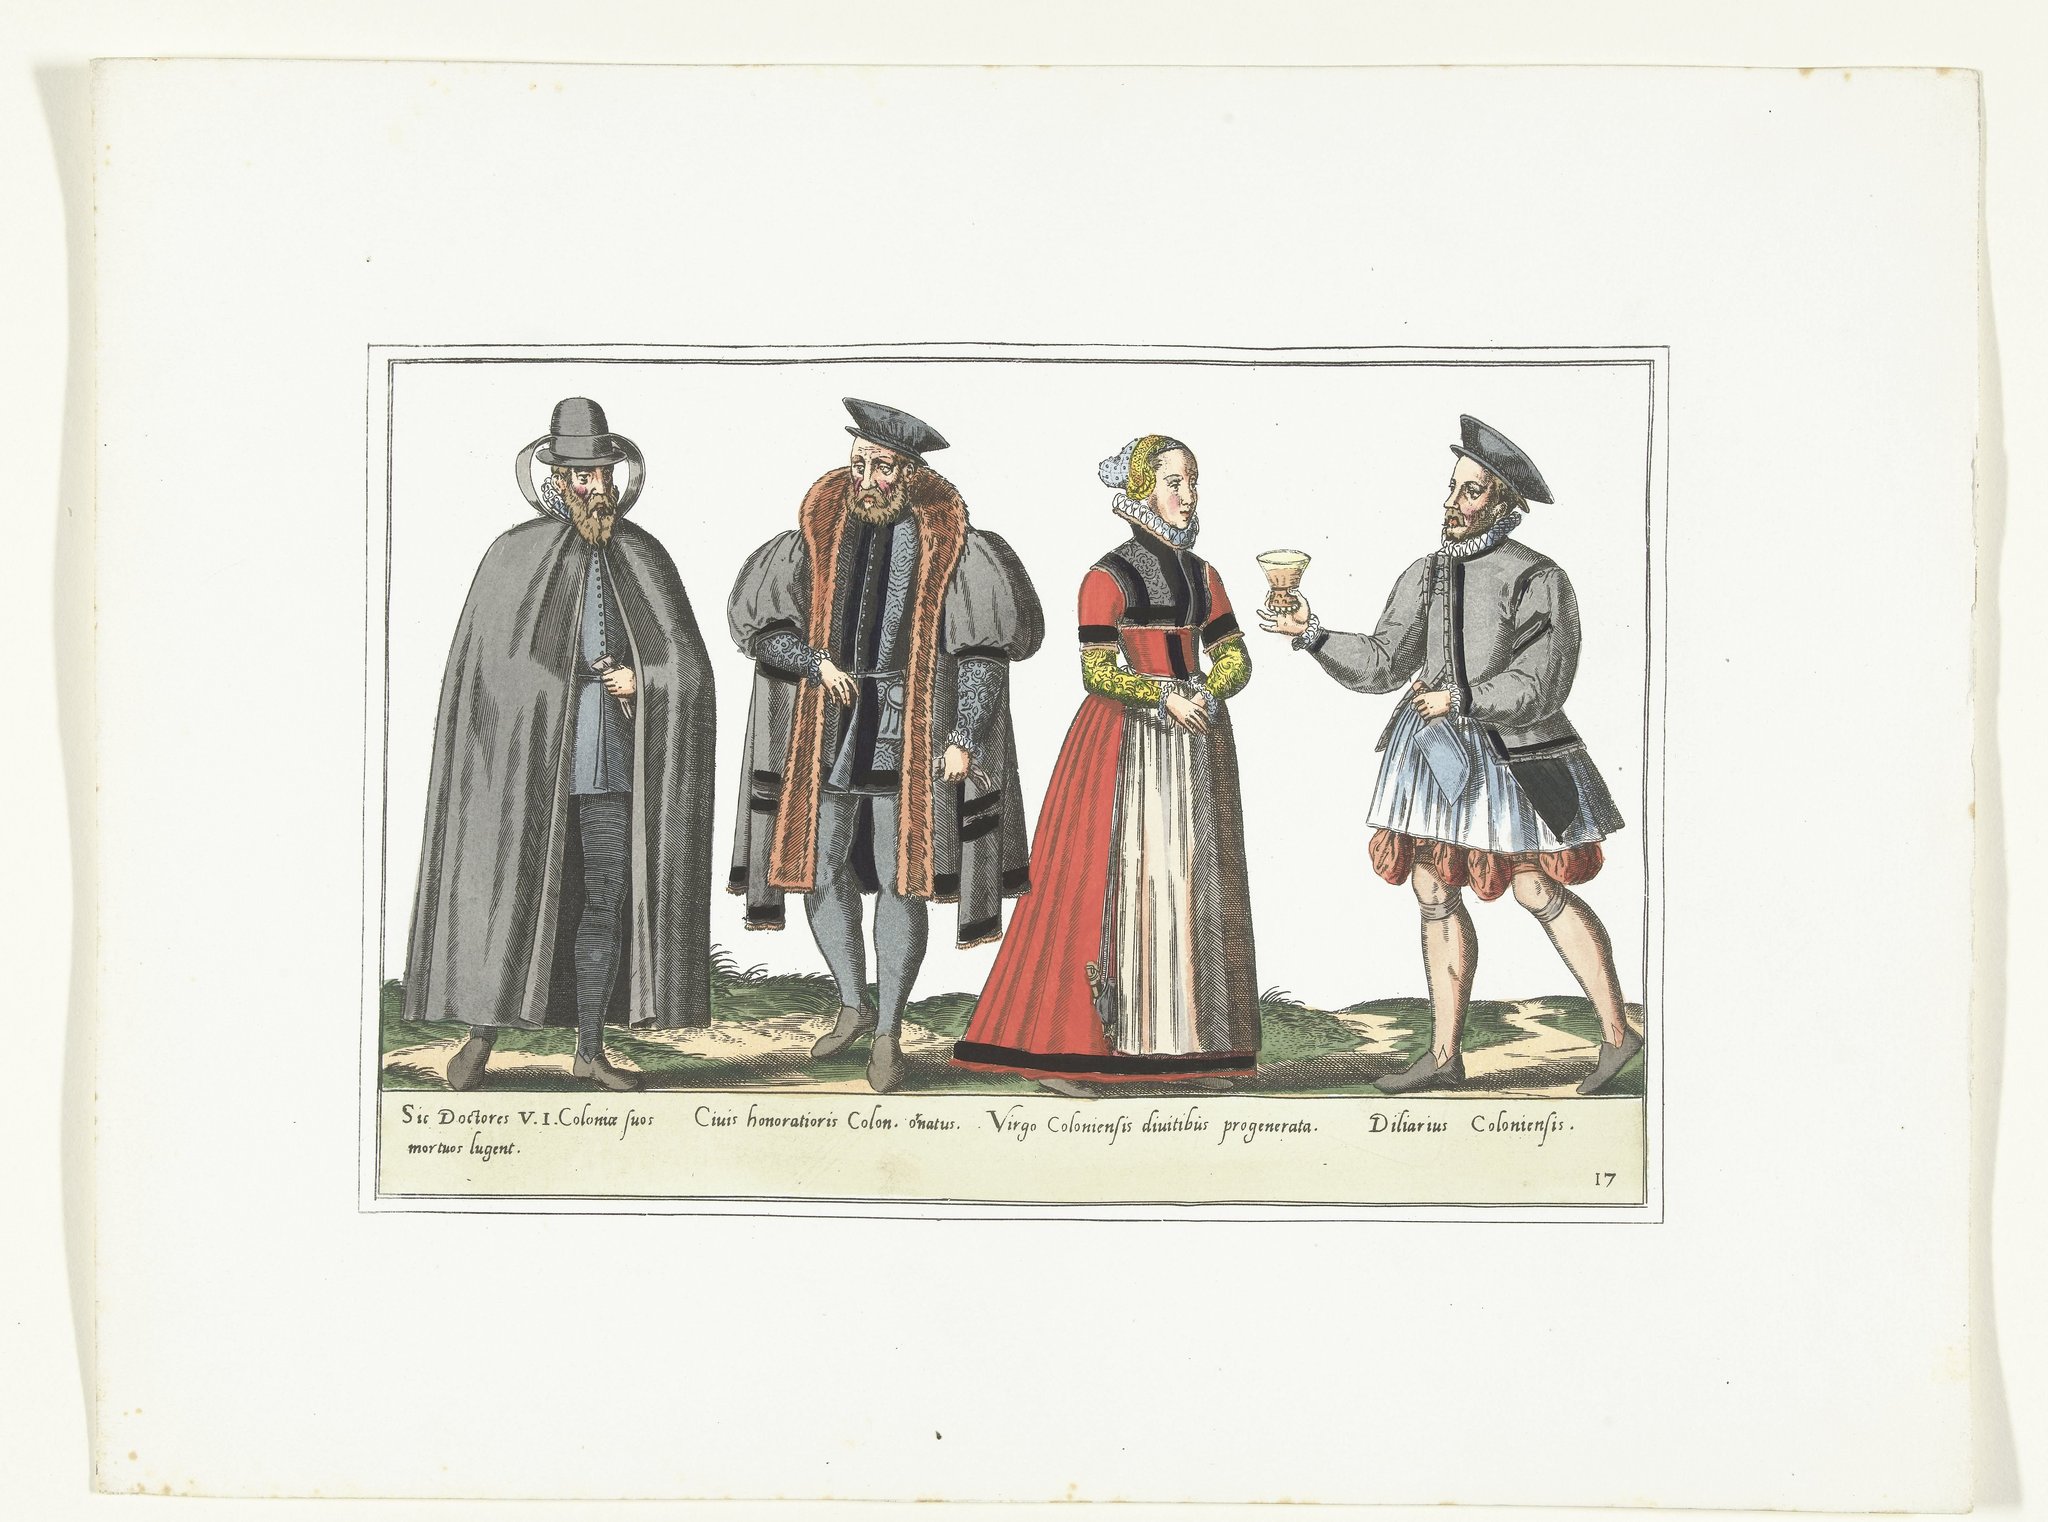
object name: costume print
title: Costumes Allemands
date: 1872-1875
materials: paper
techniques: hand coloring, printing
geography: brussels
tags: clothes, costume (+ men's clothes), germany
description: Onderdeel van Costumes civils et militaires du XVIe siècle par A. de Bruyn, een selectie van prenten uit de Trachtenbuch van Abraham de Bruyn uit 1581 (Hollstein 248-306), in facsimile. Losbladig uitgegeven met titelbladen, verklaring en lijst van de platen door G.A. van Trigt te Brussel in 1875 met teksten van Auguste Schoy. In de Rijksmuseum Research Library met signatuur 34 C 43.